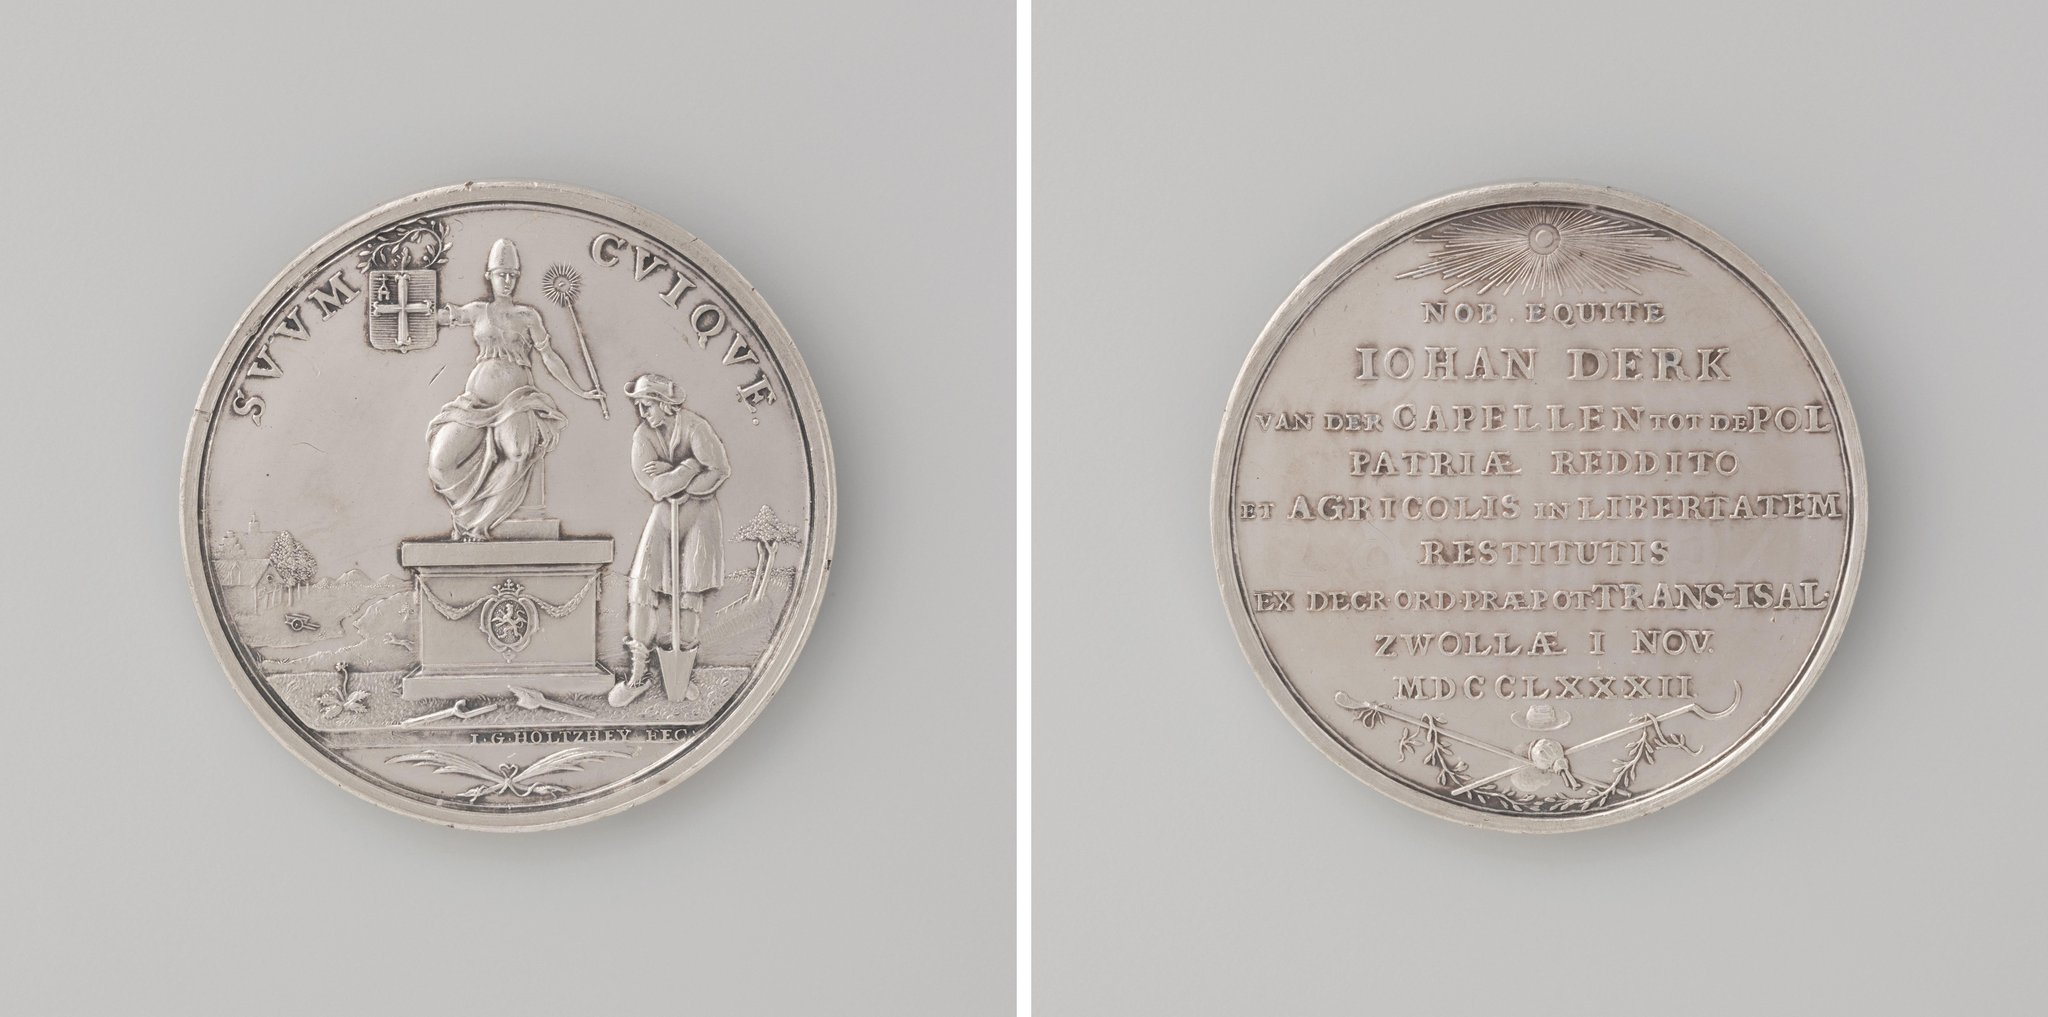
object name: history medal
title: Joan Derk van der Capellen tot den Pol weer toegelaten tot de Staten van Overijssel en afschaffing van de drostendiensten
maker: johan george holtzhey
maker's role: mintmaster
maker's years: 1726-1808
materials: silver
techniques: striking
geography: amsterdam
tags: politician, joan derk van der capellen tot den pol